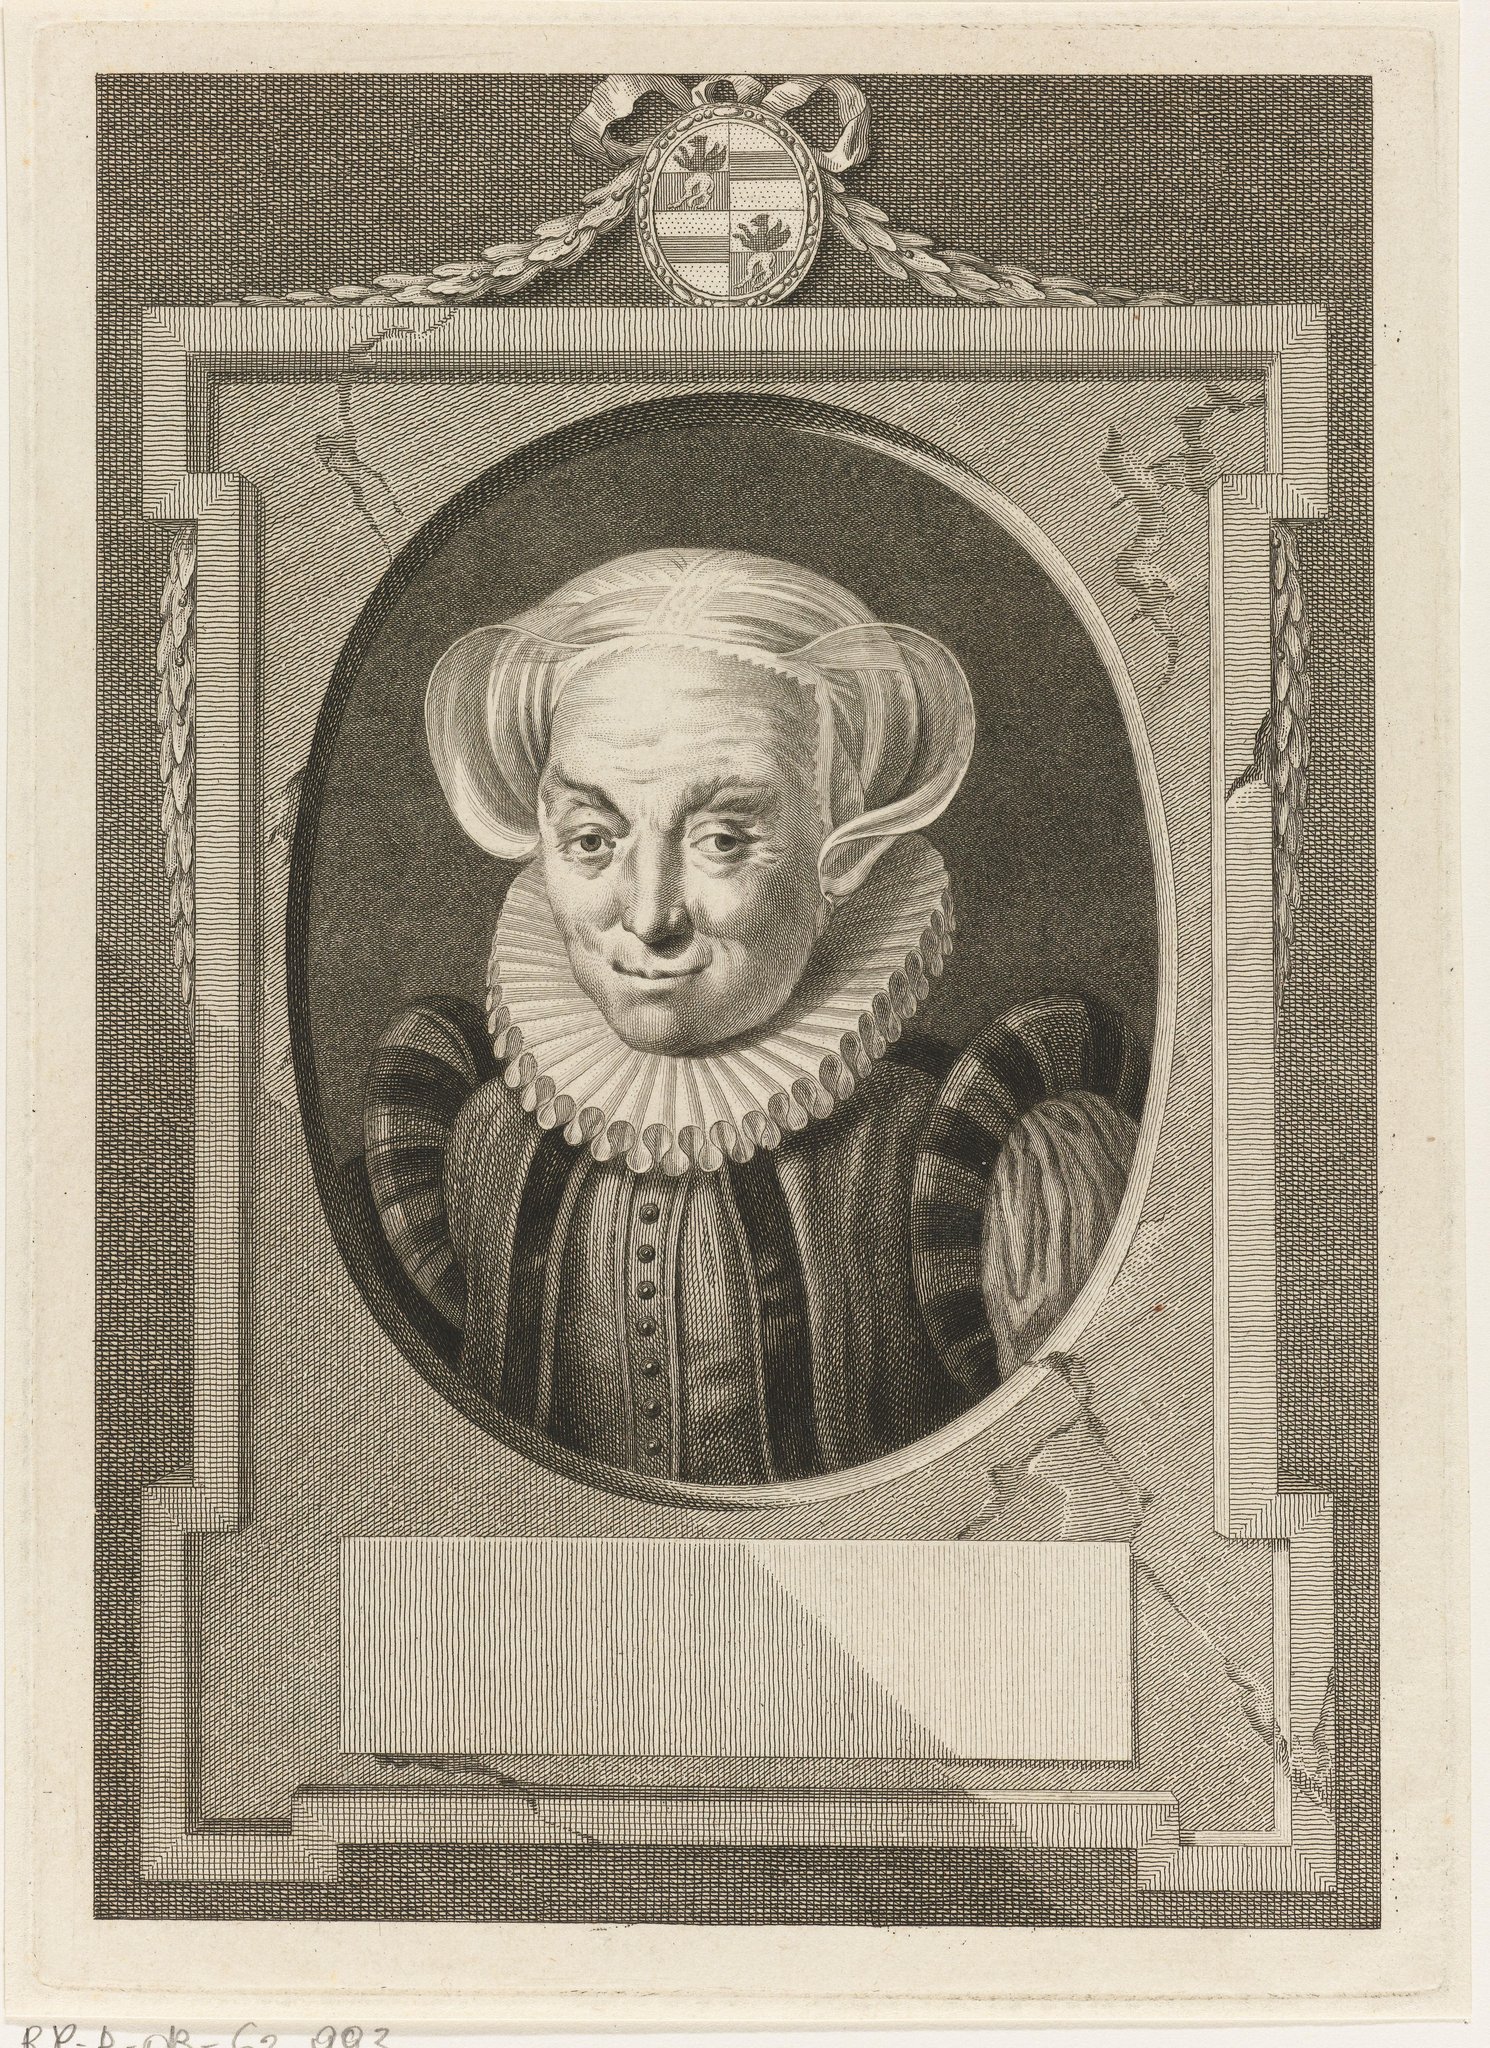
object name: print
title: Portret van Maria van Utrecht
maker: reinier vinkeles (i)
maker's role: draughtsman, print maker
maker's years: 1741-1816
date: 1772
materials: paper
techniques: engraving, etching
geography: amsterdam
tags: maria van utrecht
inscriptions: collector's mark: Lugt 2228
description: Portret van Maria van Utrecht, echtgenote van Johan van Oldenbarnevelt. Bovenaan haar wapenschil.